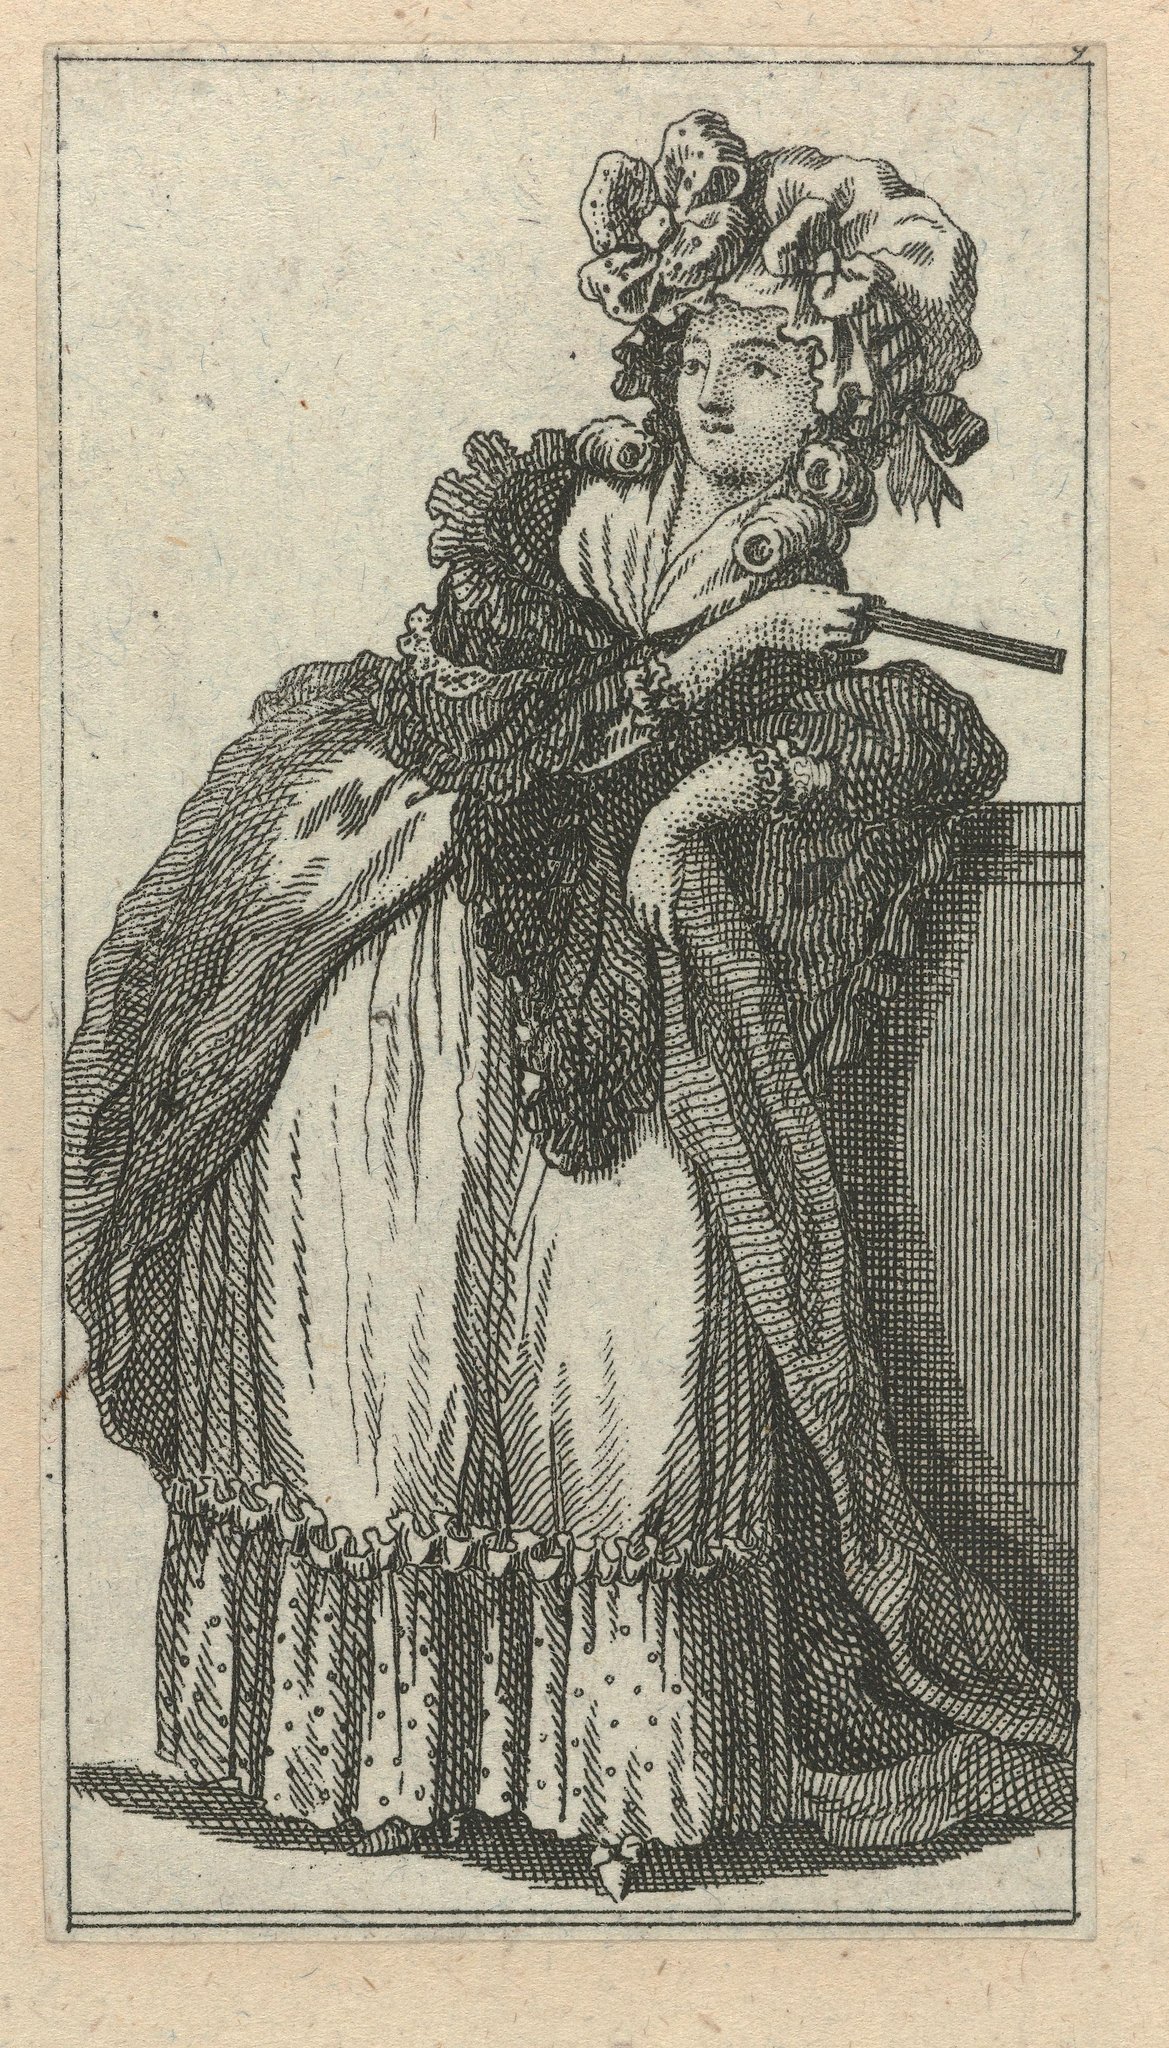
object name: almanac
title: Habillemens à la Mode:, ca. 1785. kopie naar L'aimeable Céphis (...)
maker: Anonymous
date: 1785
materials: paper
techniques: engraving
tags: calendar, almanac, dress, gown: morning dress (+ women's clothes), clothing for the upper part of the body (mantelet) (+ women's clothes), styles of hairdress - aa - ~ women, head-gear: cap (+ women's clothes), fashion plates, skirt (+ women's clothes), piece of clothing covering the breast or décolleté (fichu) (+ women's clothes)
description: Volgens het onderschrift van het origineel staat Céphise in gedachten verzonken over de afwezigheid van haar geliefde. Zij draagt een luchtige ochtendjapon en grote muts 'à la Charlotte'. Om de hals een fichu. Kleine schoudermantel afgezet met een geplooide strook stof; gesloten vouwwaaier in de hand. De prent is een gespiegelde en verkleinde kopie naar aaa 288, uit serie aaa. 45e Cahier de Costumes Français, 40e Suite d'Habillemens à la mode en 1785, Gallerie des Modes et Costumes Français.